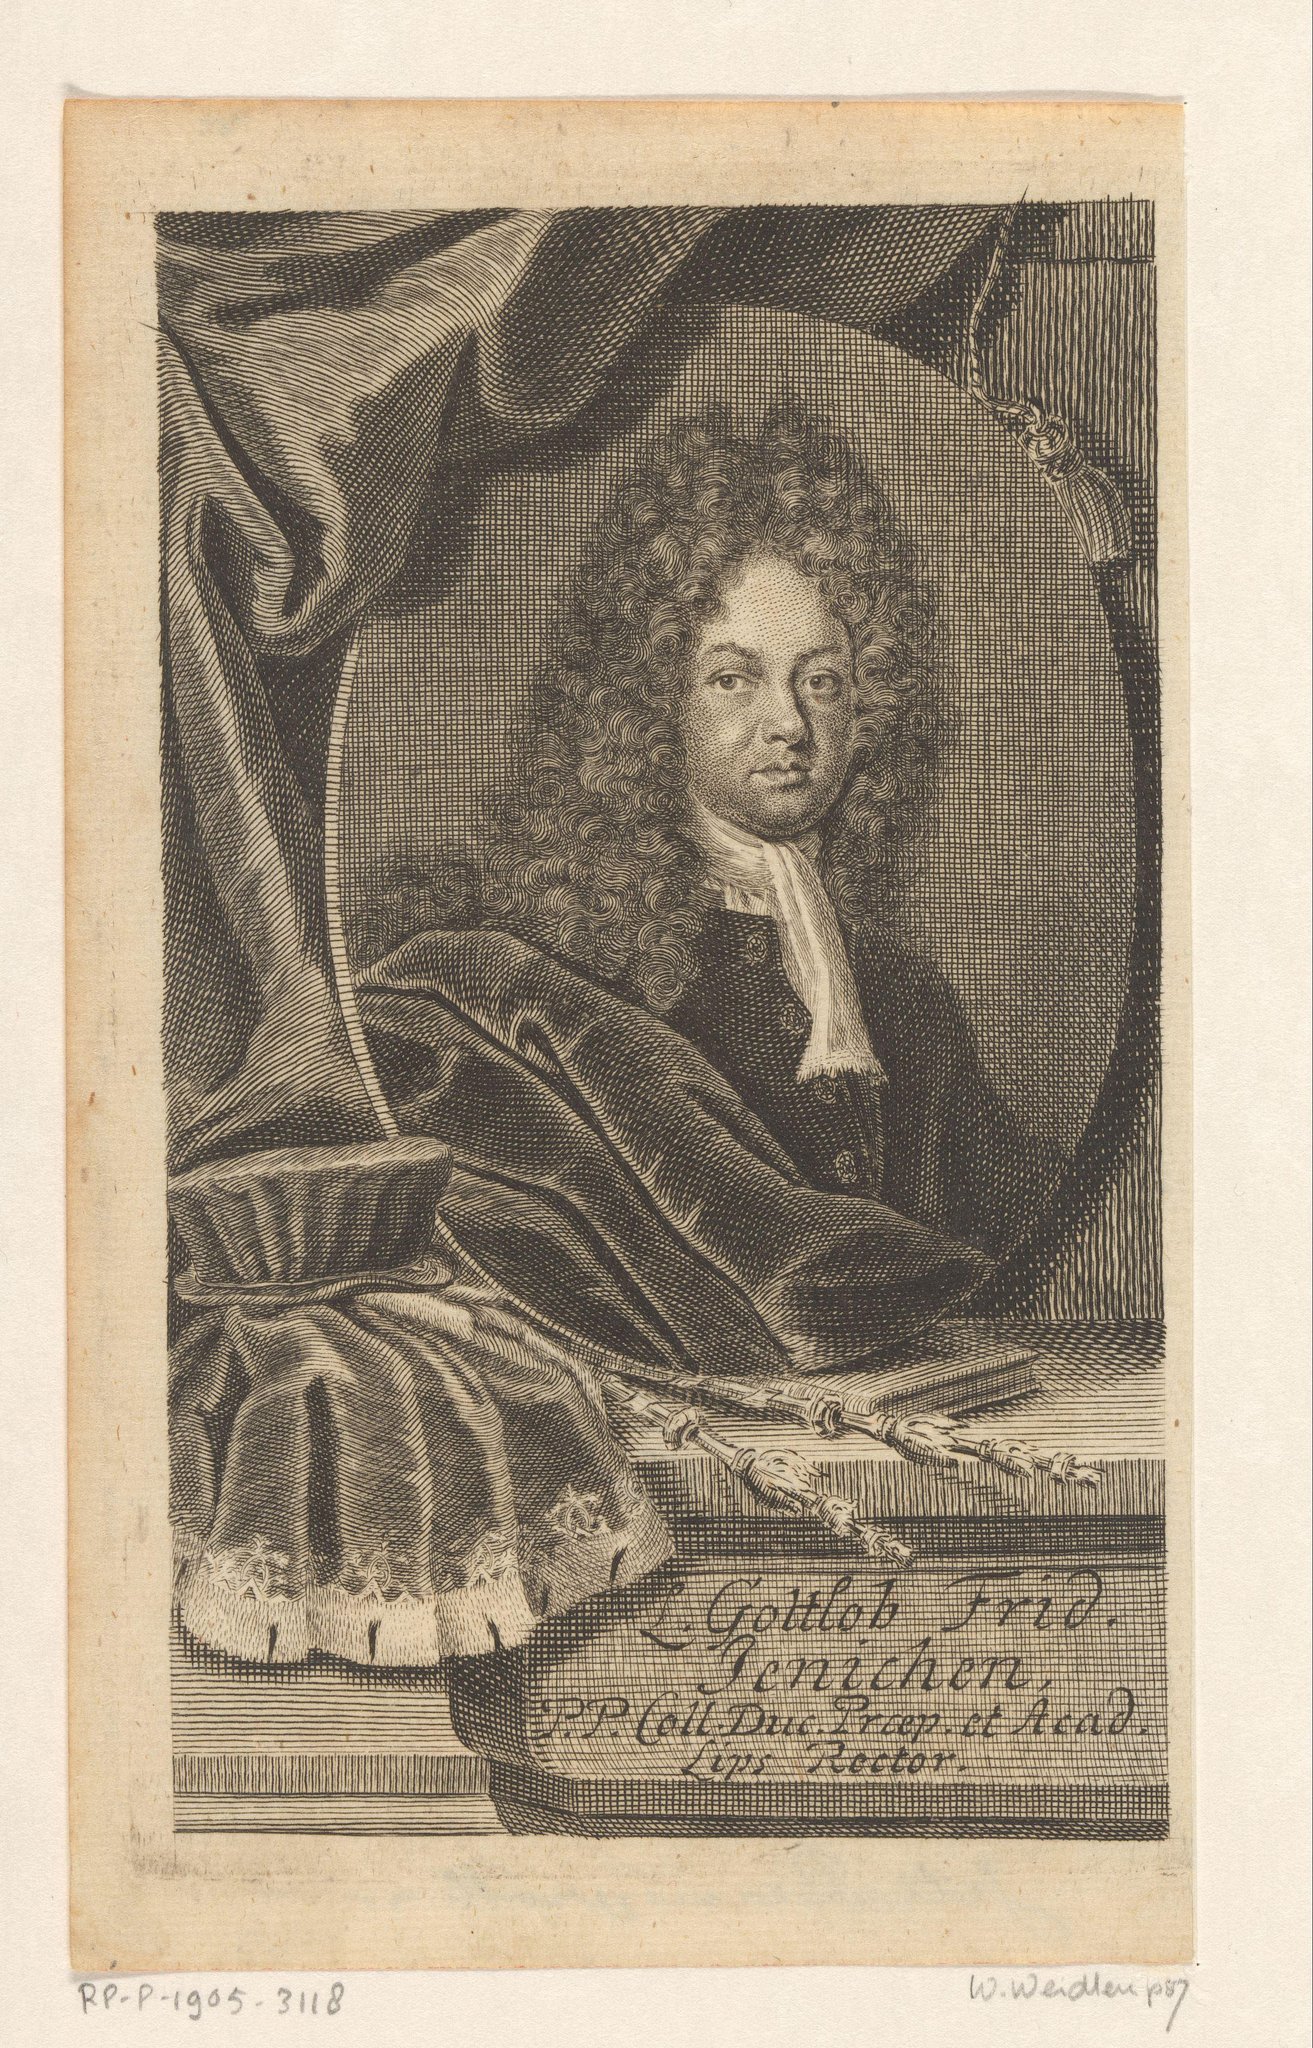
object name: print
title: Portret van Gottlob Friedrich Jenichen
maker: martin bernigeroth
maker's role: print maker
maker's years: 1670-1733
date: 1716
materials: paper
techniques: engraving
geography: leipzig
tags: board, dignitaries of a university, historical persons, book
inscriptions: collector's mark: Lugt 2228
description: Prent ook gebruikt in: Deutsche Acta Eruditorum (...). dl. 41. Leipzig: Johann Gottlieb Gleditsch, 1716.